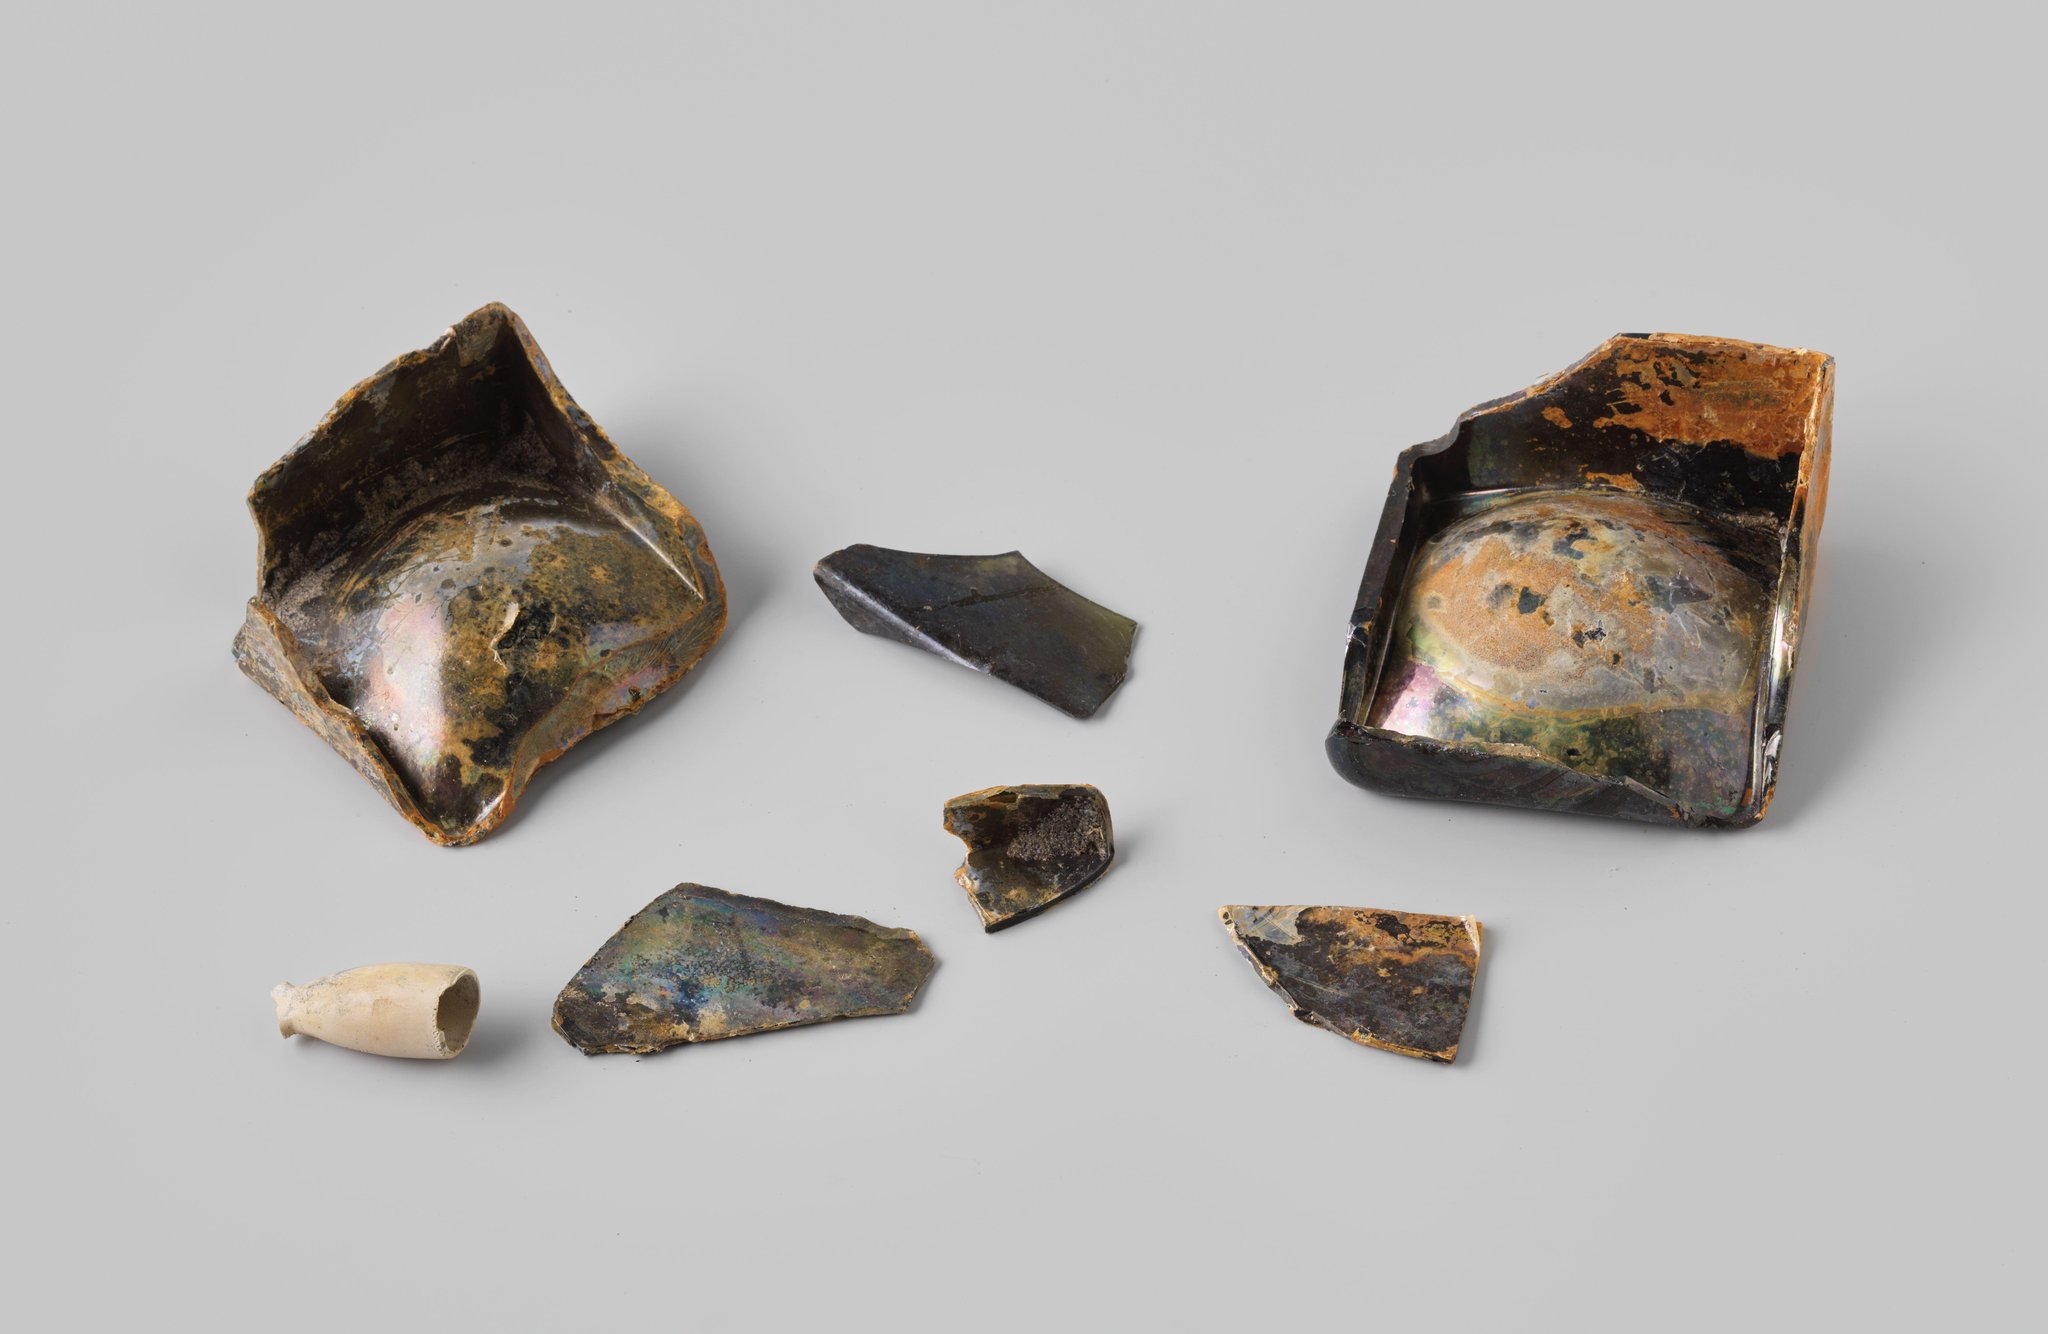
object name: case bottle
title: Scherven van kelderflessen en een pijpenkop uit het wrak van de Oost-Indiëvaarder 't Vliegend Hart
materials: glass, clay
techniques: green glass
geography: middelburg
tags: 't vliegend hart (schip), verenigde oostindische compagnie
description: Vijf grote fragmenten van vierkante kelderflessen: twee bodems en vier schreven. Eén pijpekop met hielmerk gekroonde 67. Case bottle.